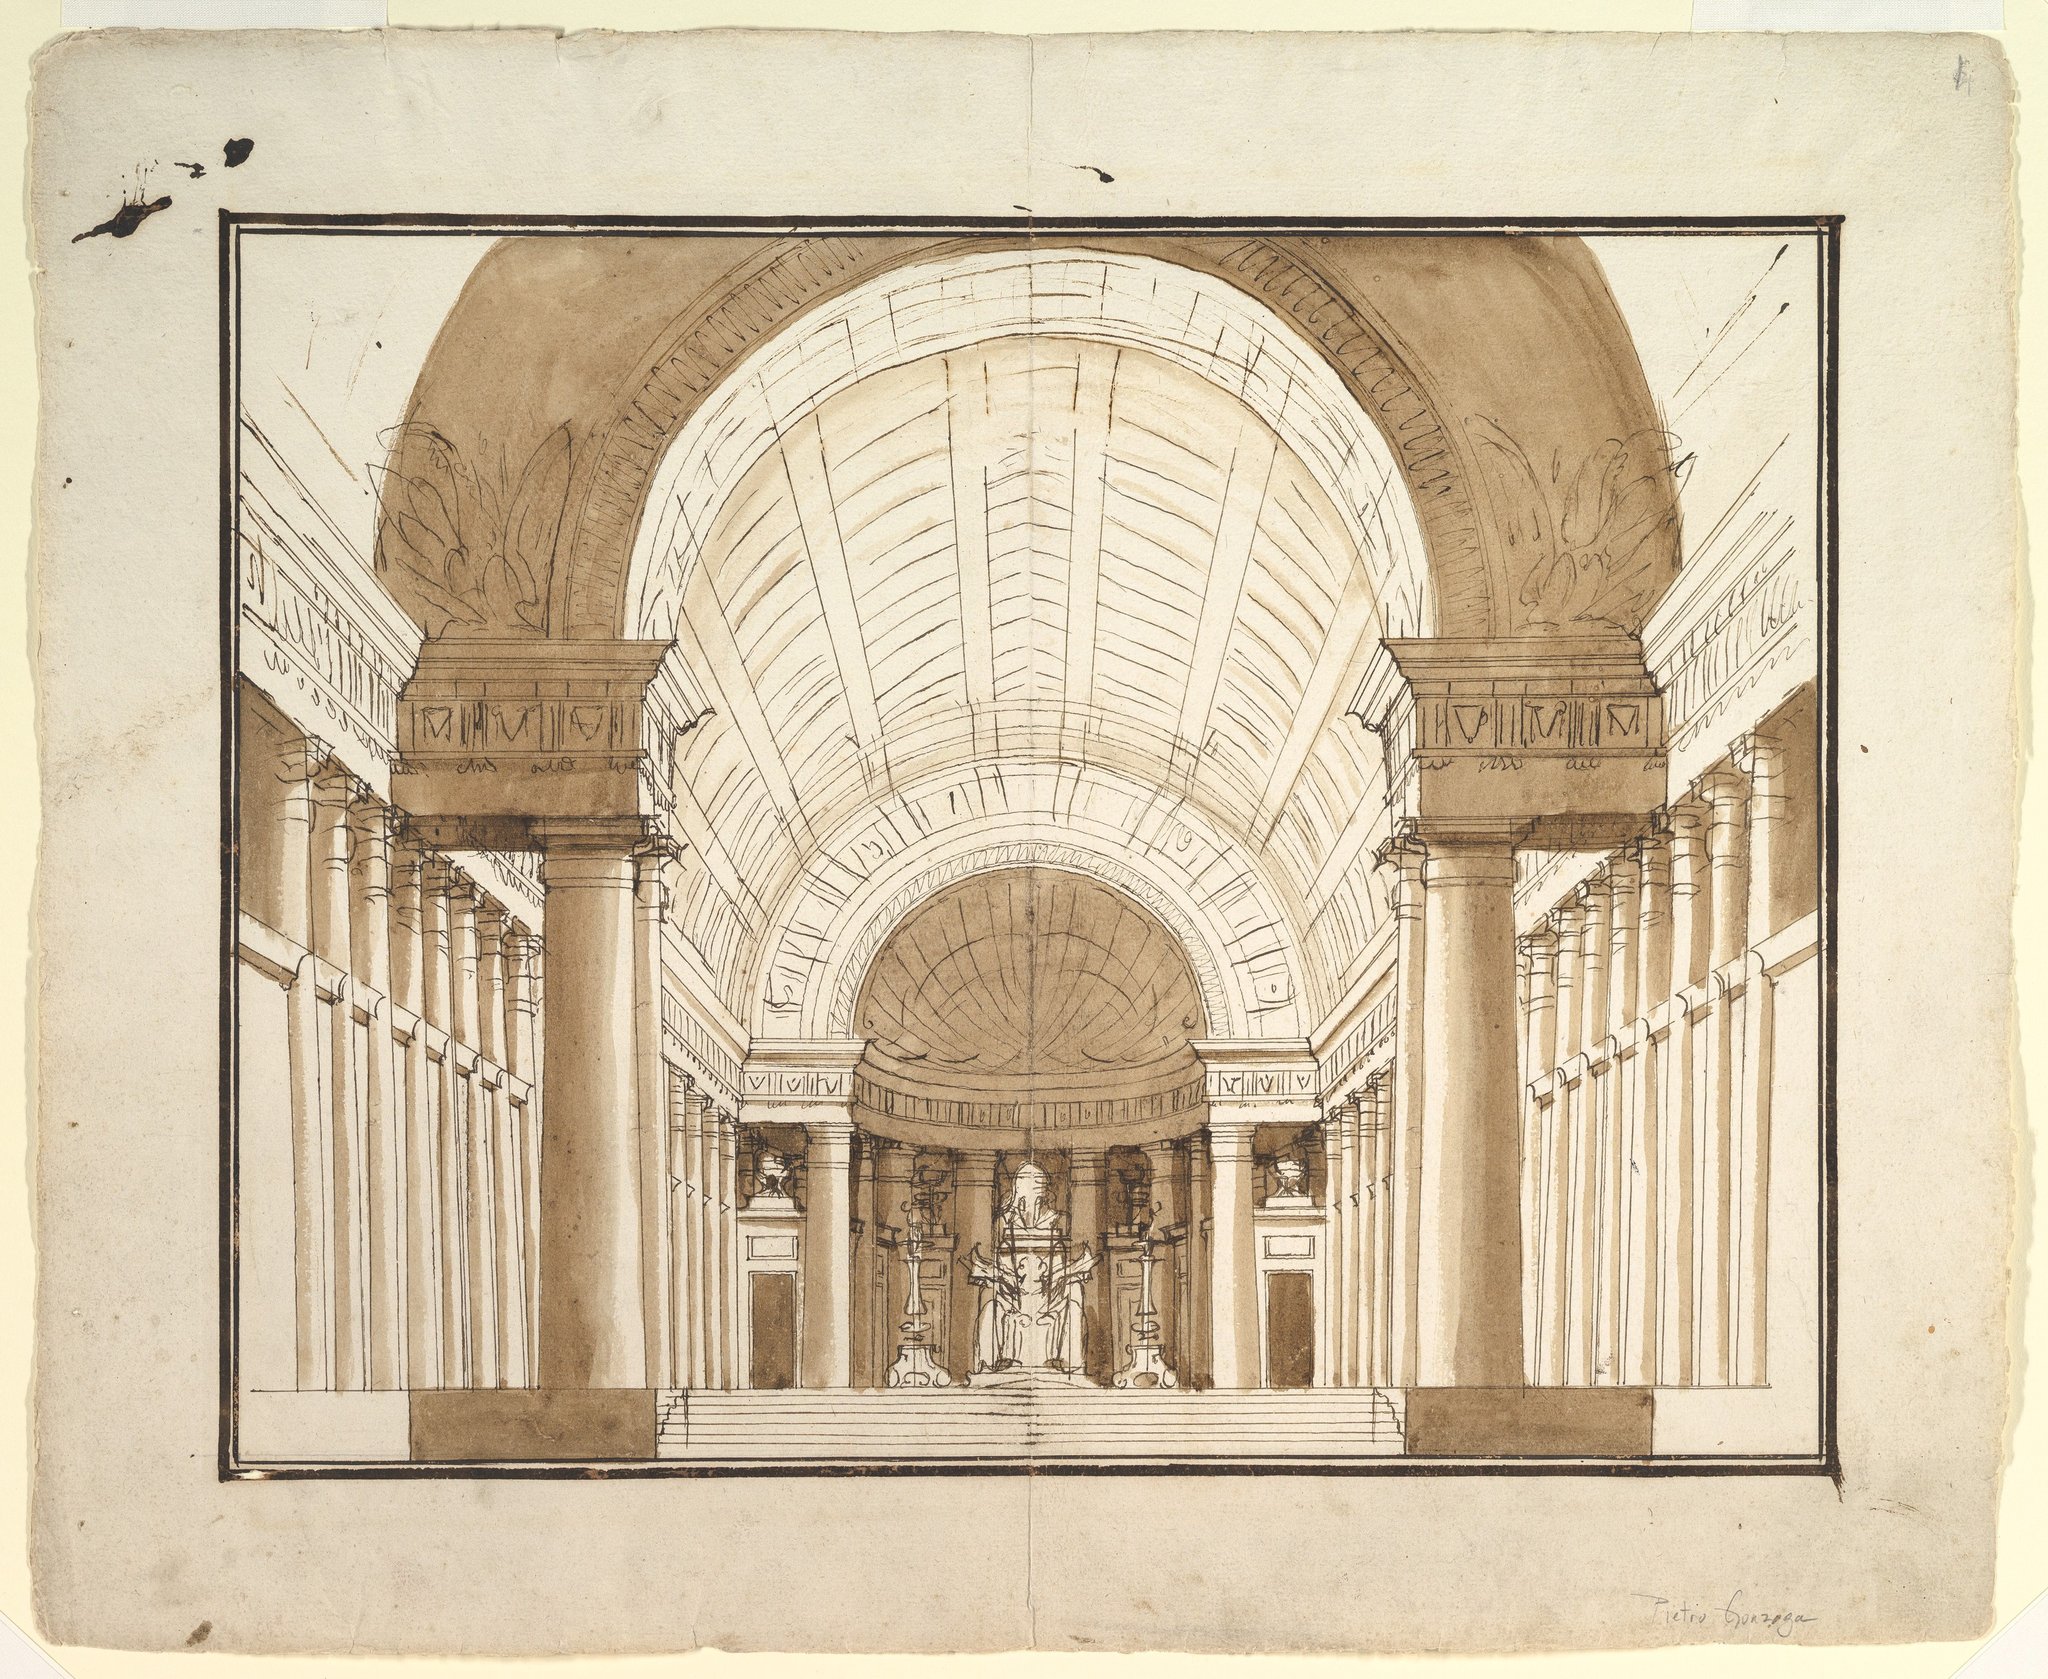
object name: drawing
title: Set Design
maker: pietro di gottardo gonzaga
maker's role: artist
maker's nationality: italian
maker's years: 1751-1831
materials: ink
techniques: brush, pen, wash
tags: arches,columns,stage design